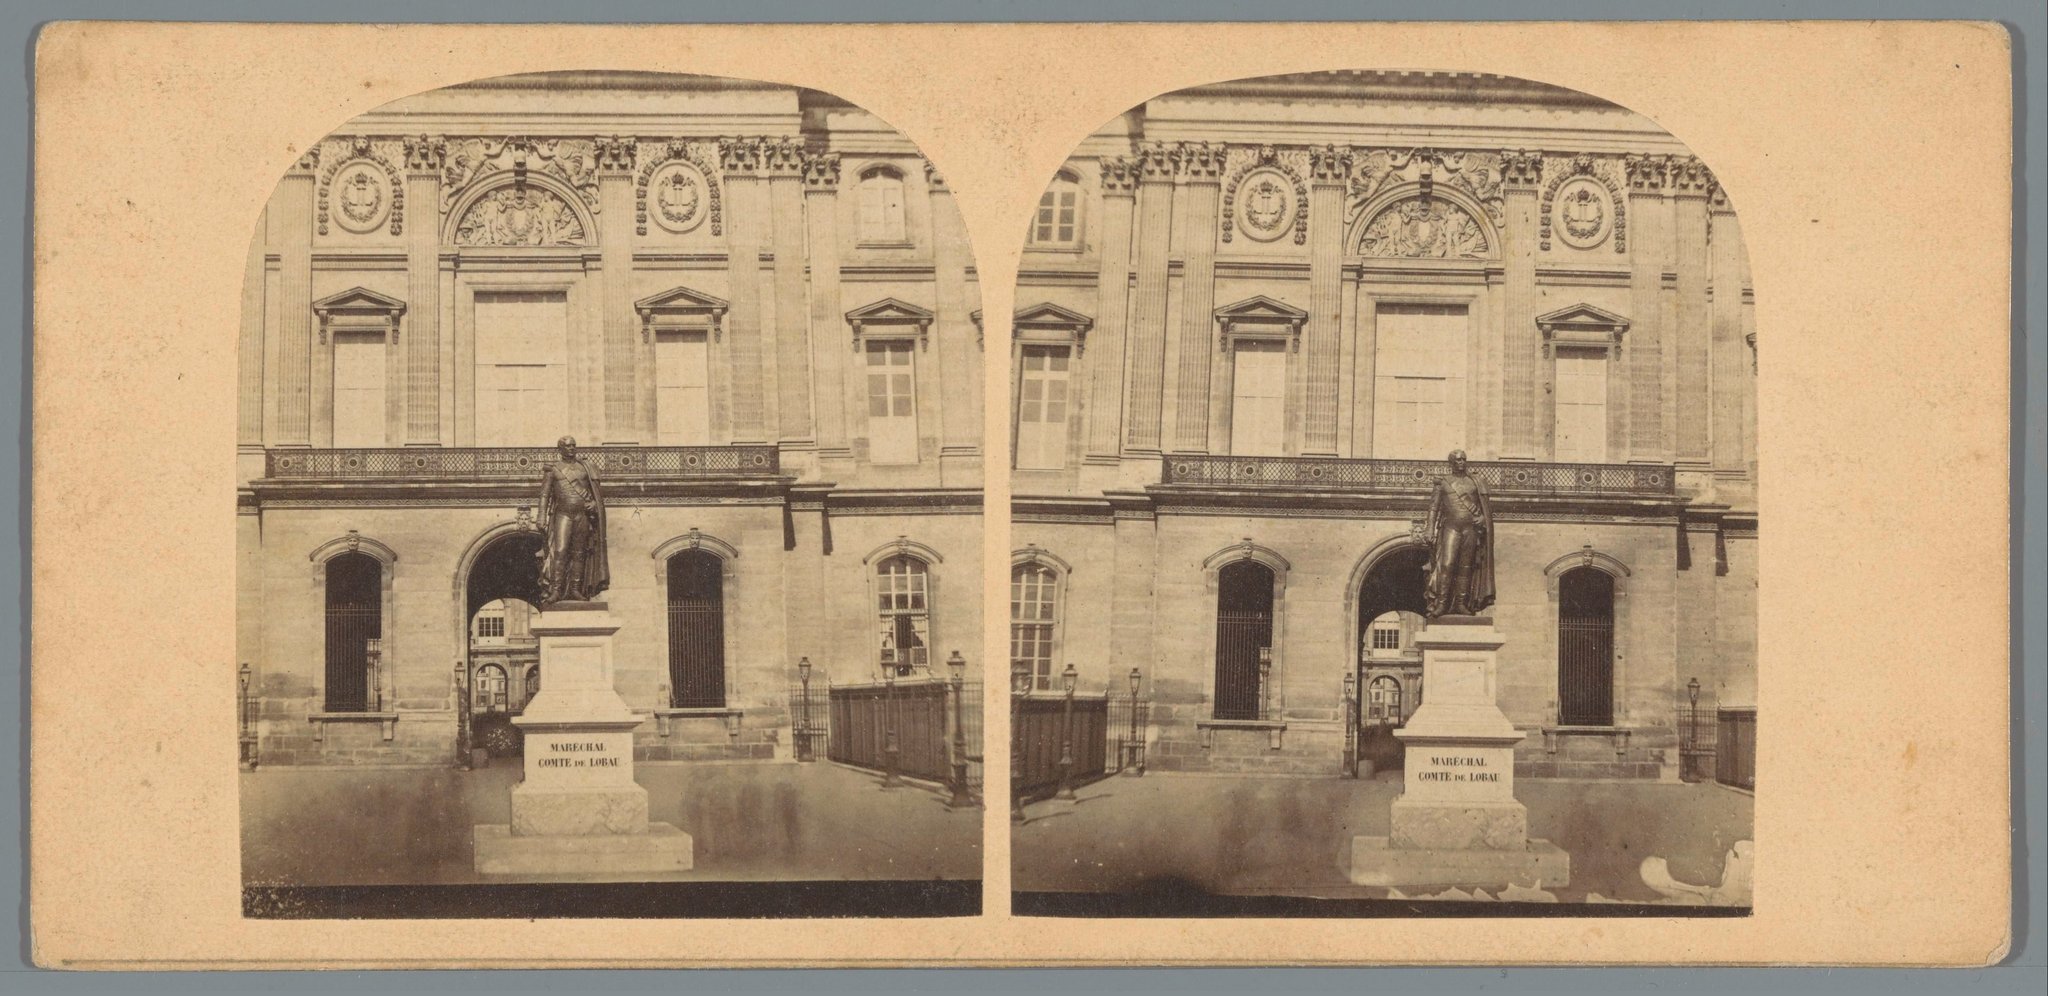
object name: stereograph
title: Gezicht op een standbeeld van Georges Mouton in de Rue de Lobau in Parijs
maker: Anonymous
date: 1850-1880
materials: cardboard, photographic support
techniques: albumen print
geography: paris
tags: monument, statue, paris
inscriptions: inscription: ‘Marechal Lobau Paris. Rue de Lobau’, number: ‘54’